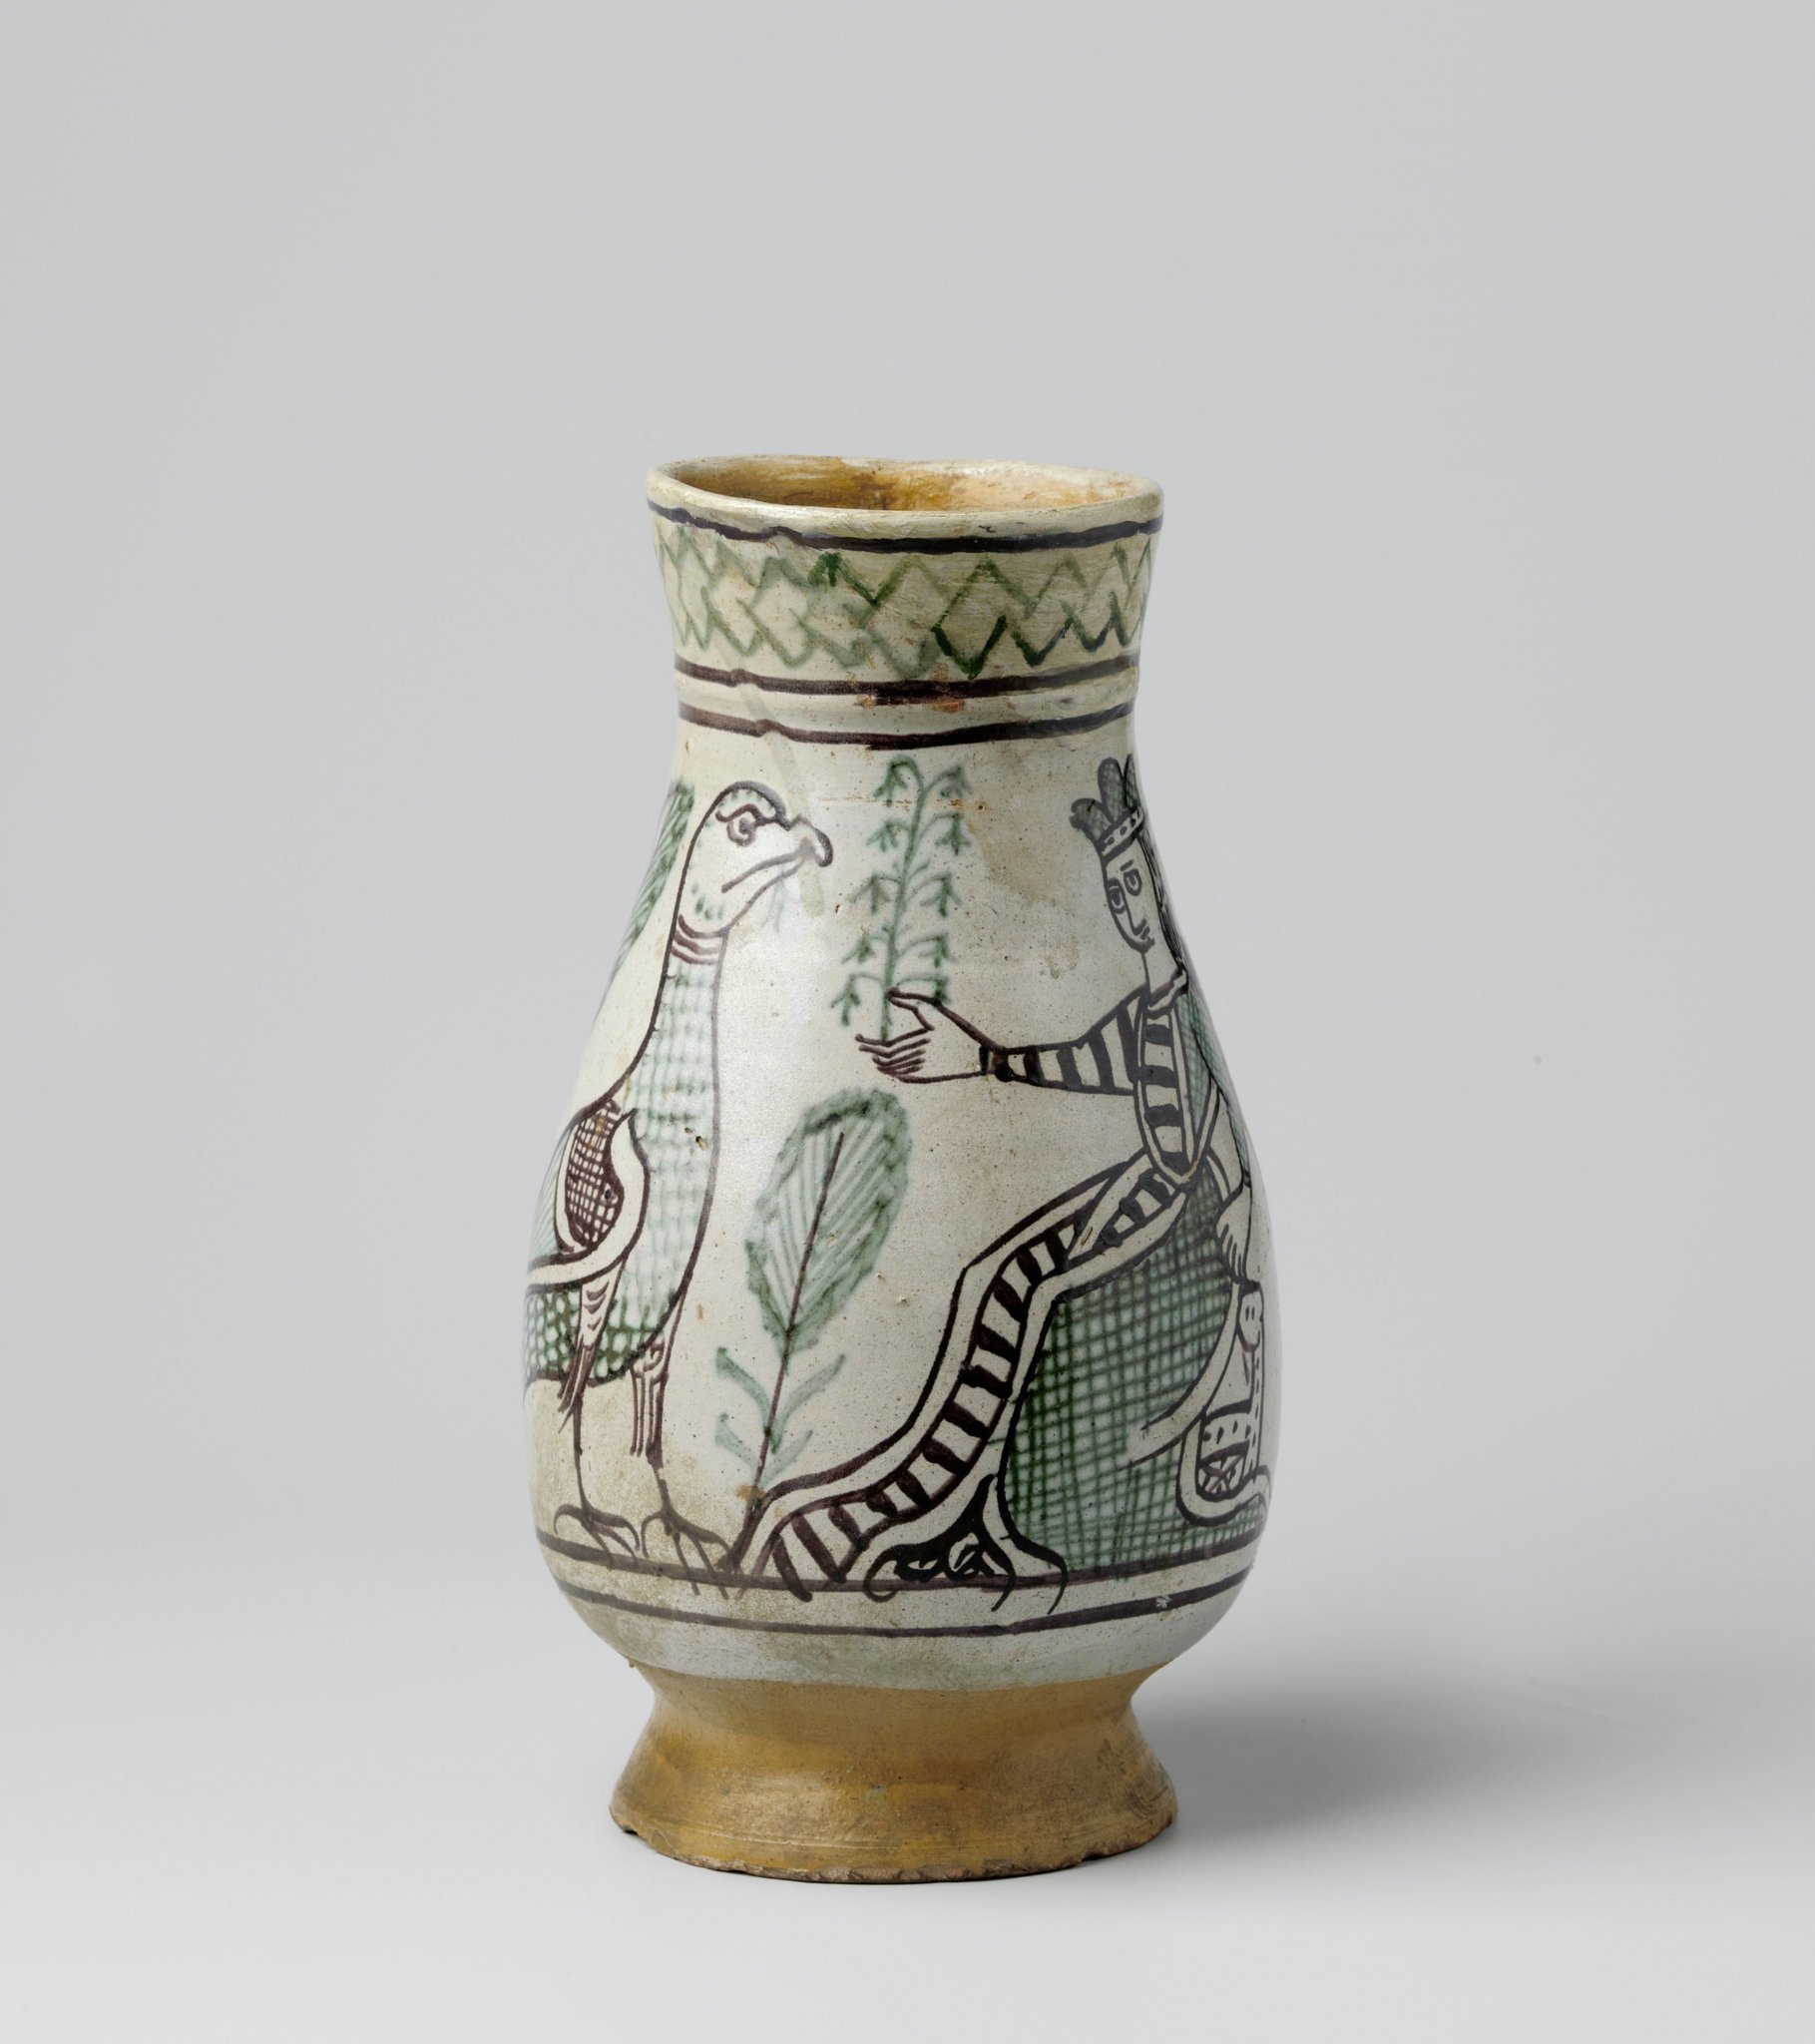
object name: ewer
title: Kan, omgekeerd balustervormig, met oor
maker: Anonymous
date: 1400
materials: earthenware, glaze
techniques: maiolica, painted, polychromy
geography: orvieto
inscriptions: collector's mark: ‘Chenu[e] / emballeur/ 5, Rue de la Terrasse, Paris (in rood gedrukt) Br[...mogelijk Brauer] / [...] / 10 (in bruin geschreven)’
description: Jug with a queen on a throne. Central Italy, c. 1400. J.W. Edwin vom Rath bequest, 1941.